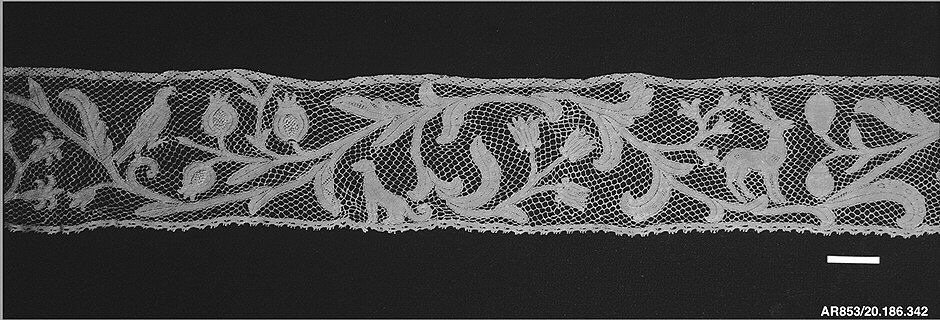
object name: border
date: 1701-1733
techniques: lace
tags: animals,birds,flowers